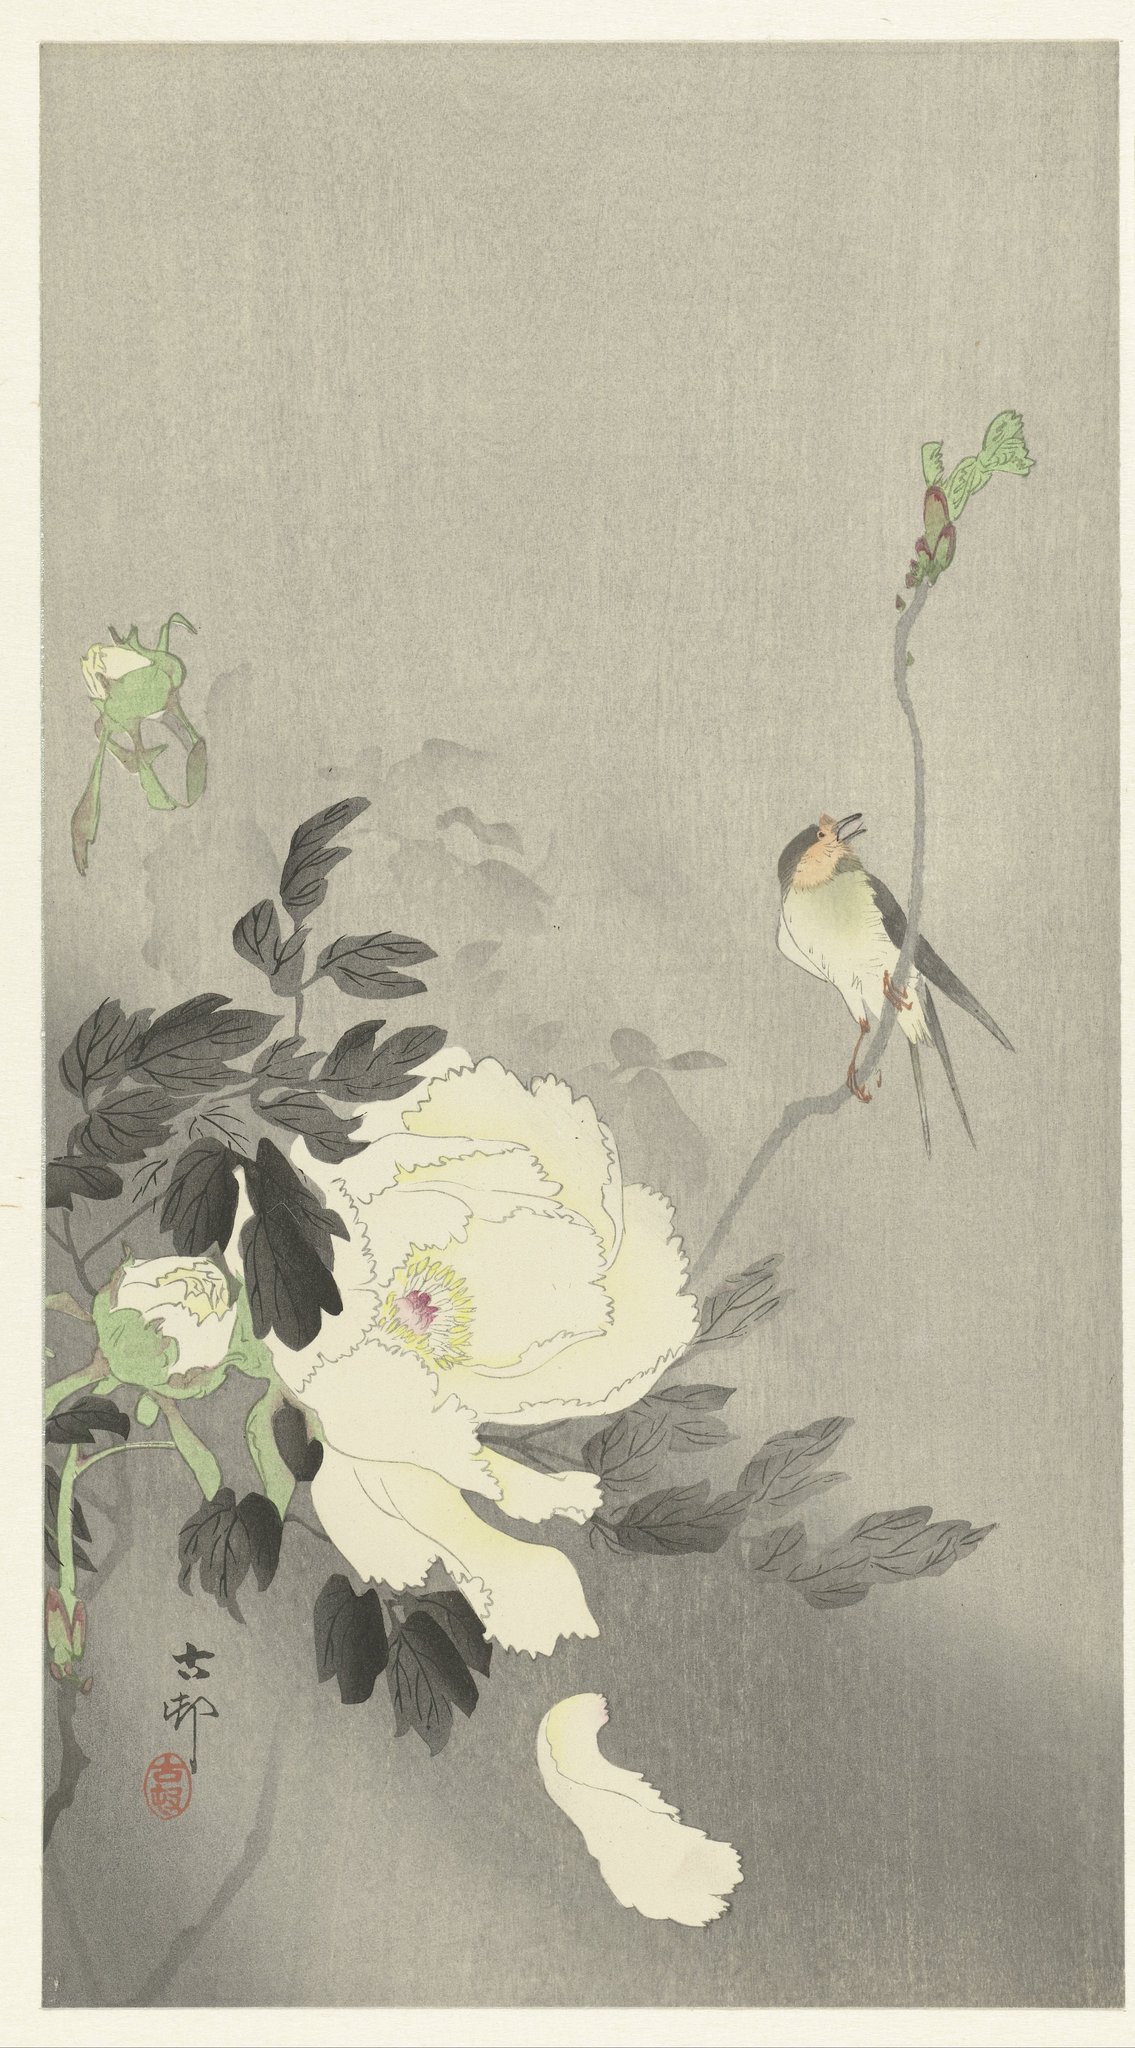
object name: print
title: Swallow with Peony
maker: ohara koson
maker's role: print maker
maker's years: 1877-1945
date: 1900-1930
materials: paper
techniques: woodcut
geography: tokyo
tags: plants and herbs: peony, birds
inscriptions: collector's mark: Lugt 2228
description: Vogel op tak bij bloeiende witte pioenroos.